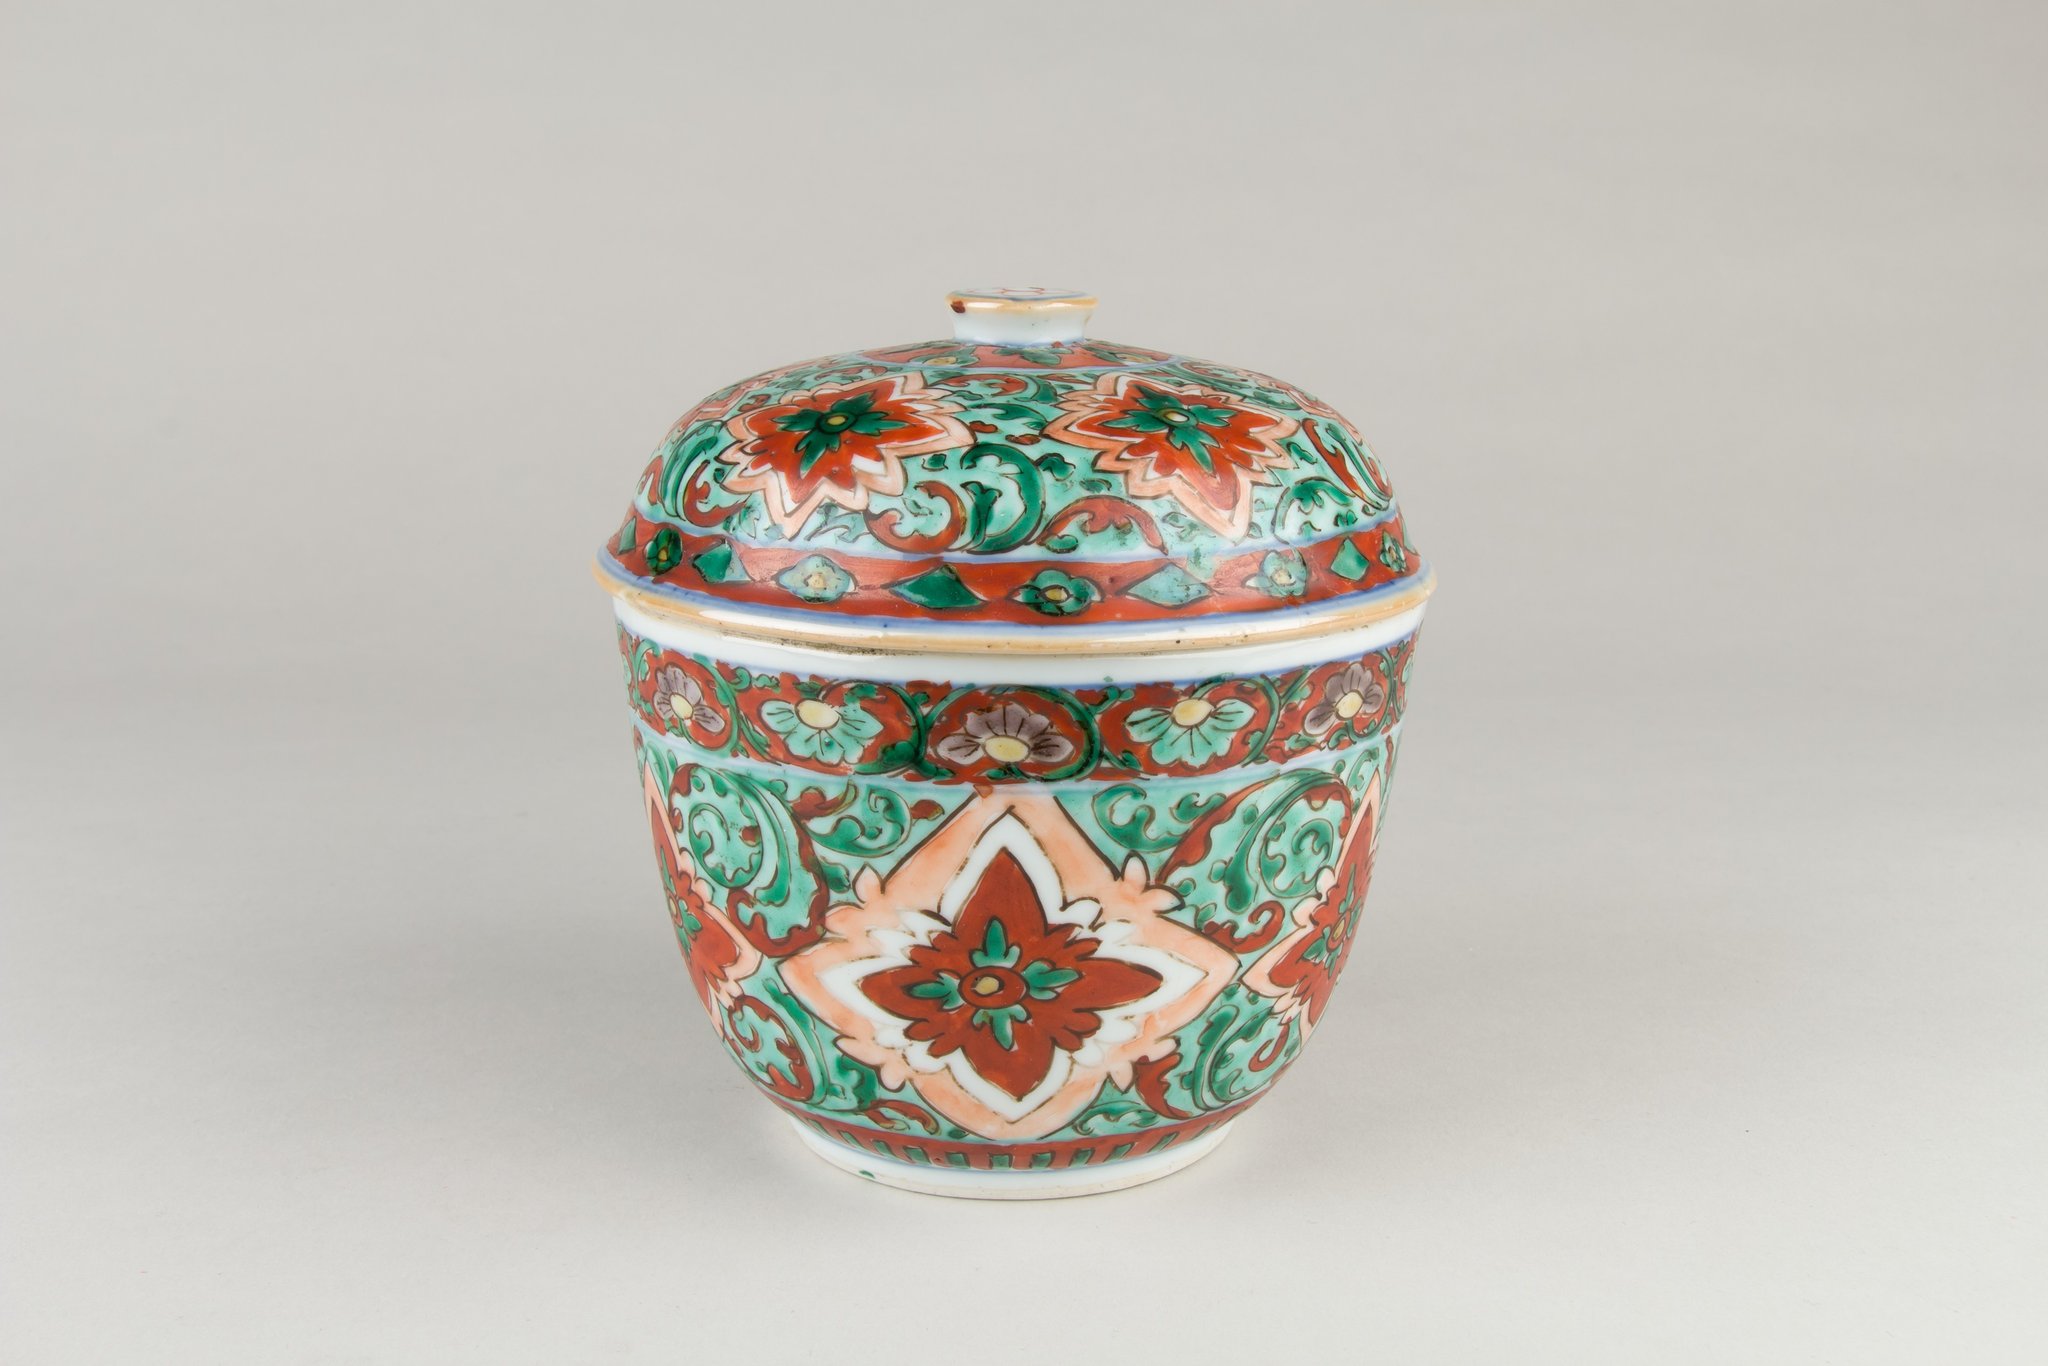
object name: bowl with lid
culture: chinese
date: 1662-1722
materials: enamel, porcelain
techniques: overglaze, polychrome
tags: flowers